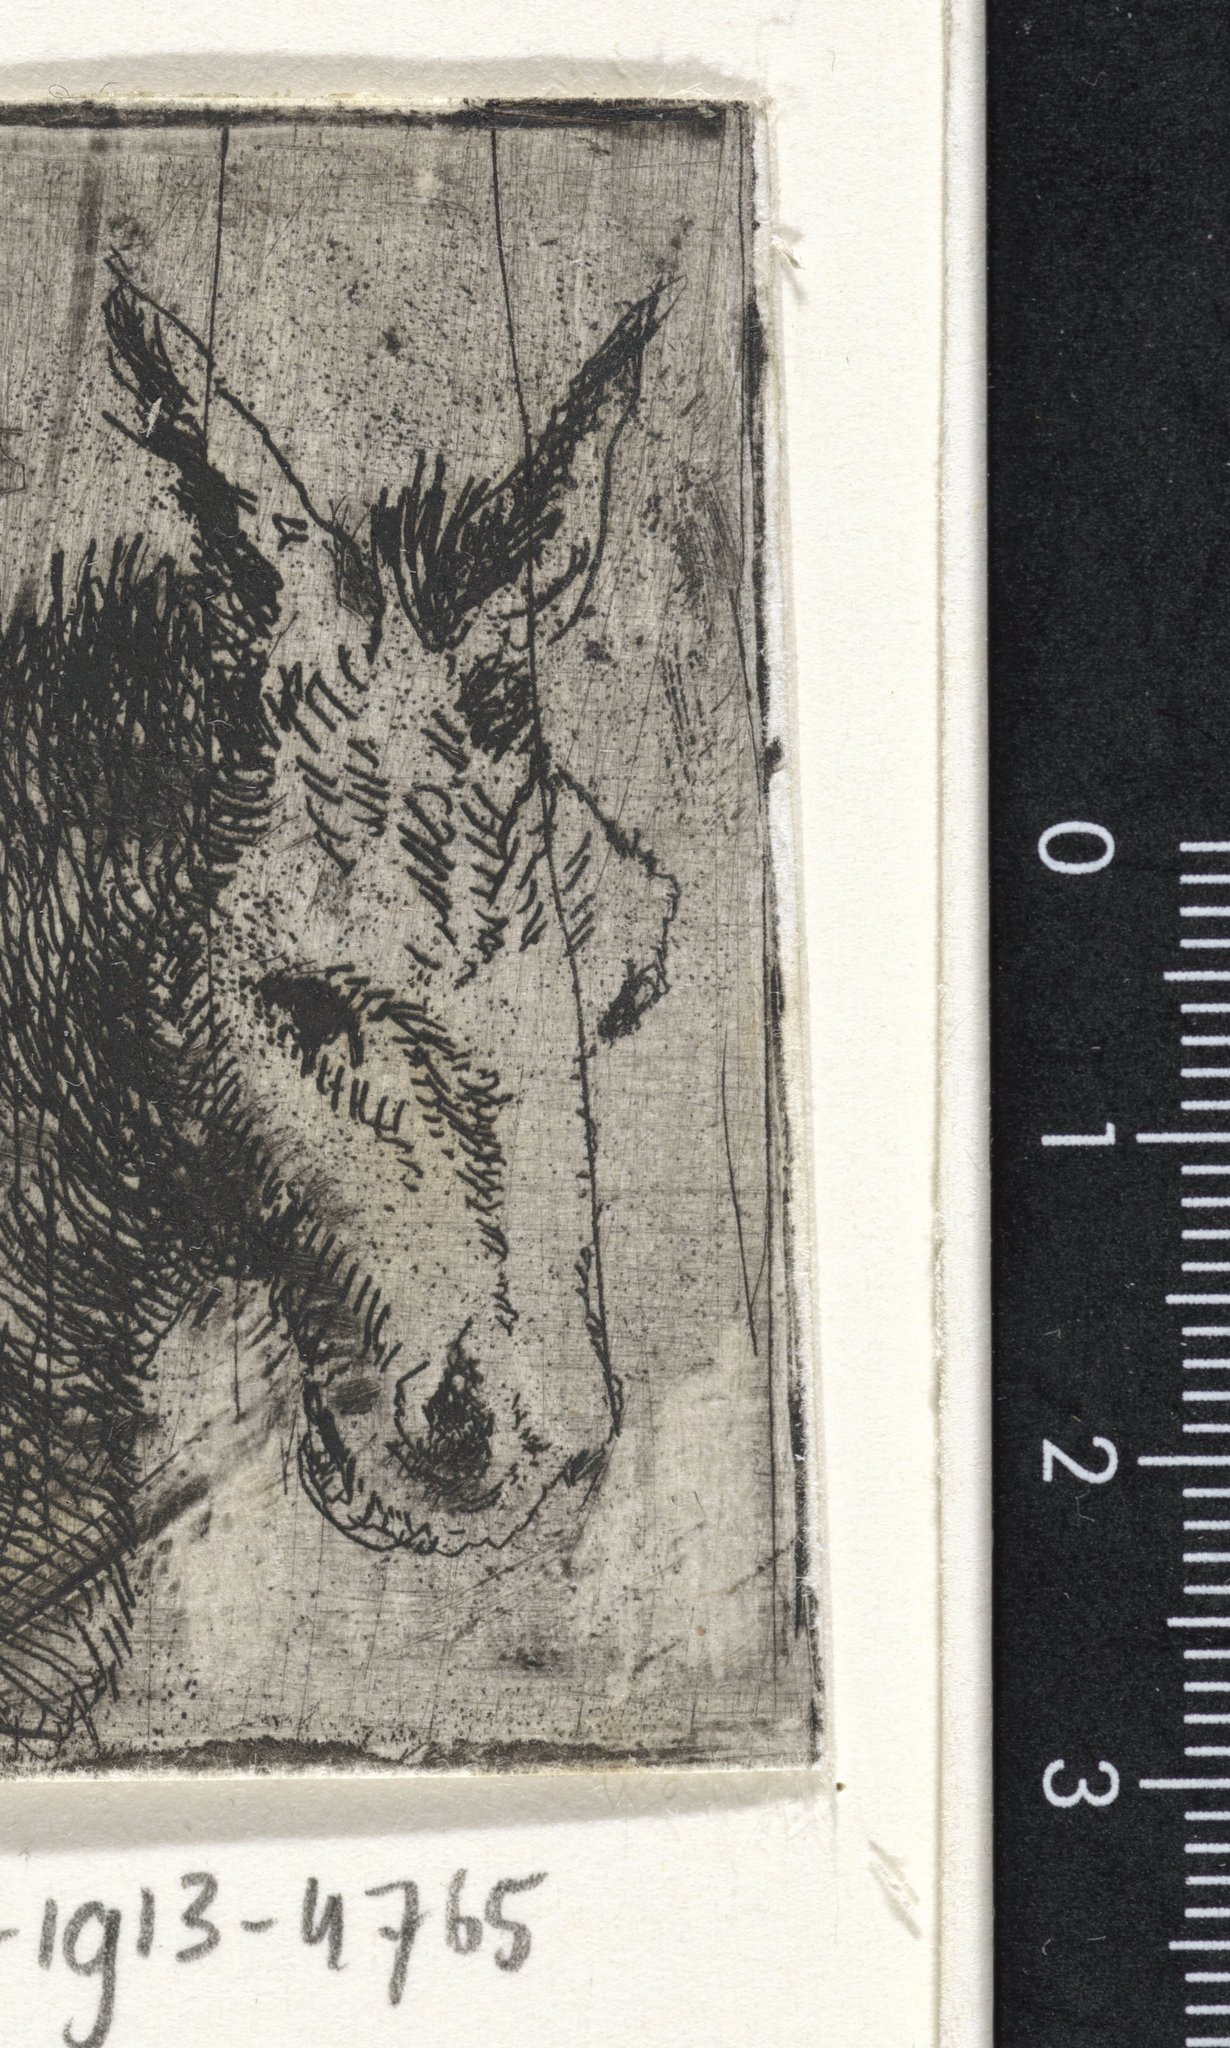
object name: print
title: Ezelskop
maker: arnoud schaepkens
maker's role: print maker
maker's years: 1816-1904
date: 1831-1904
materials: paper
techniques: drypoint, etching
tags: ass, donkey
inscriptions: collector's mark: Lugt 2228